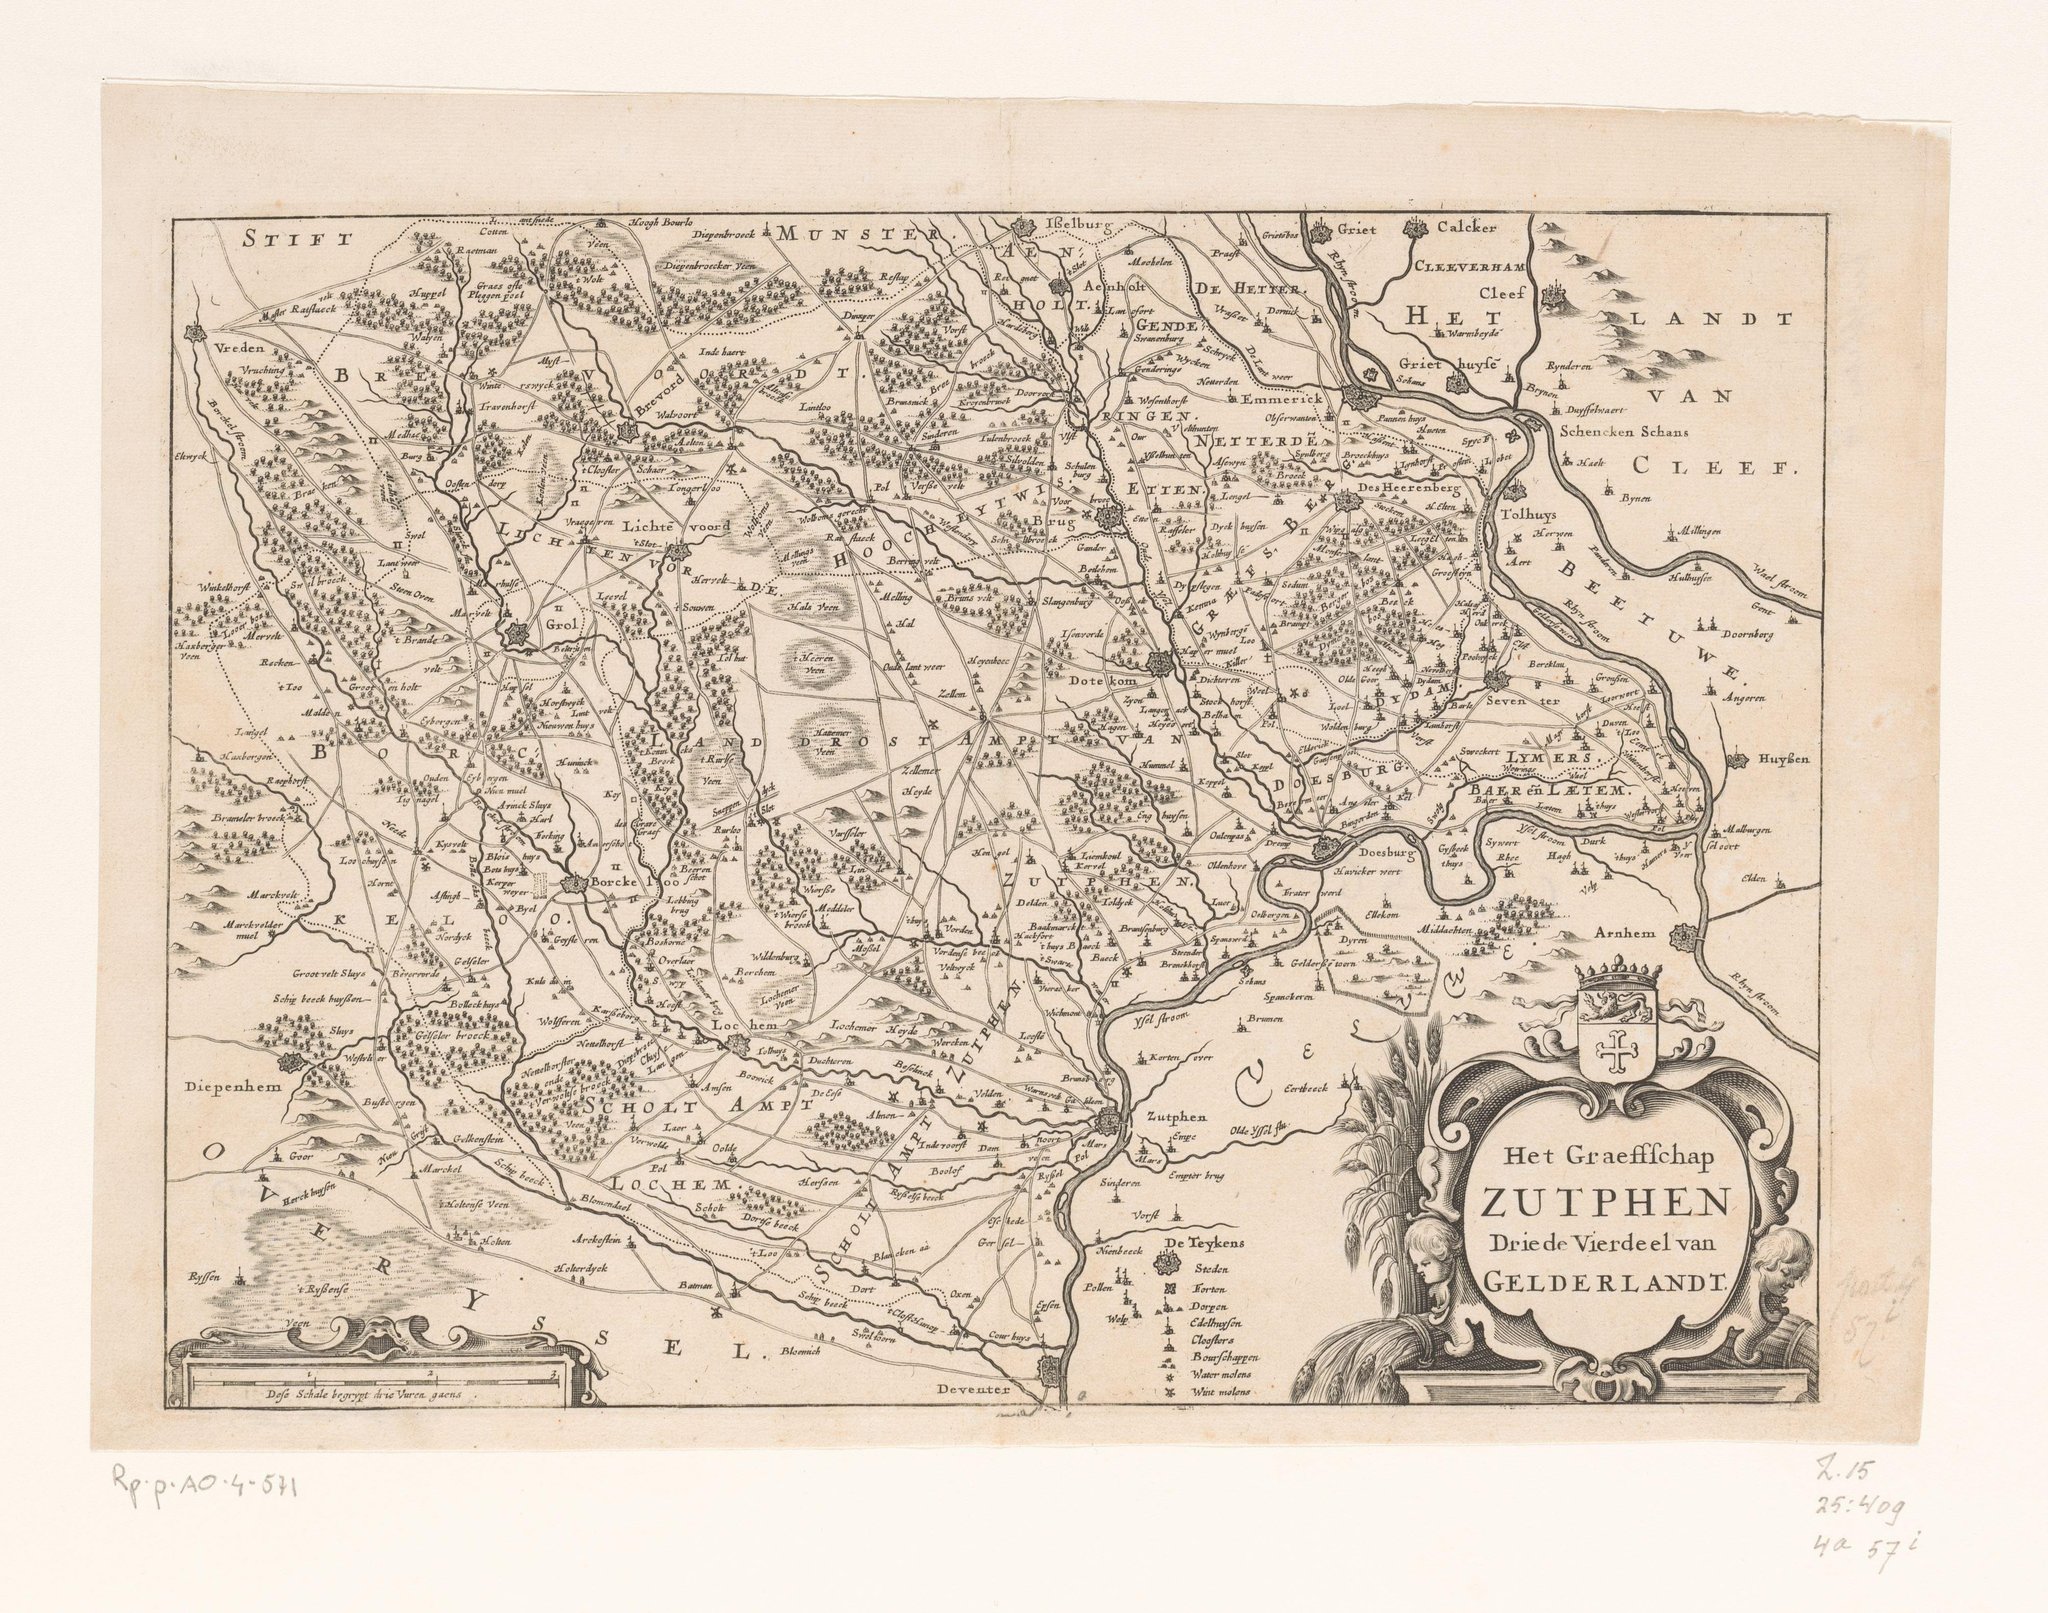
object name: print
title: Het Graeffschap Zutphen Driede Vierdeel van Gelderlandt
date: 1653-1654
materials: paper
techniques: engraving, etching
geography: arnhem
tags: coat of arms (as symbol of the state, etc.) (+ city; municipal), maps of separate countries or regions, gelderland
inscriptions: collector's mark: Lugt 2228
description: Prent ook gebruikt in: Slichtenhorst, Arend. XIV. Boeken van de Geldersse geschiedenissen: van 't begin af vervolghd tot aen de afzweeringh des konincx van Spanien (...). Arnhem: Jacob van Biesen, 1653. En in: Slichtenhorst, Arend. XIV. Boeken van de Geldersse geschiedenissen: van 't begin af vervolghd tot aen de afzweeringh des konincx van Spanien (...). Arnhem: Jacob van Biesen, 1654.